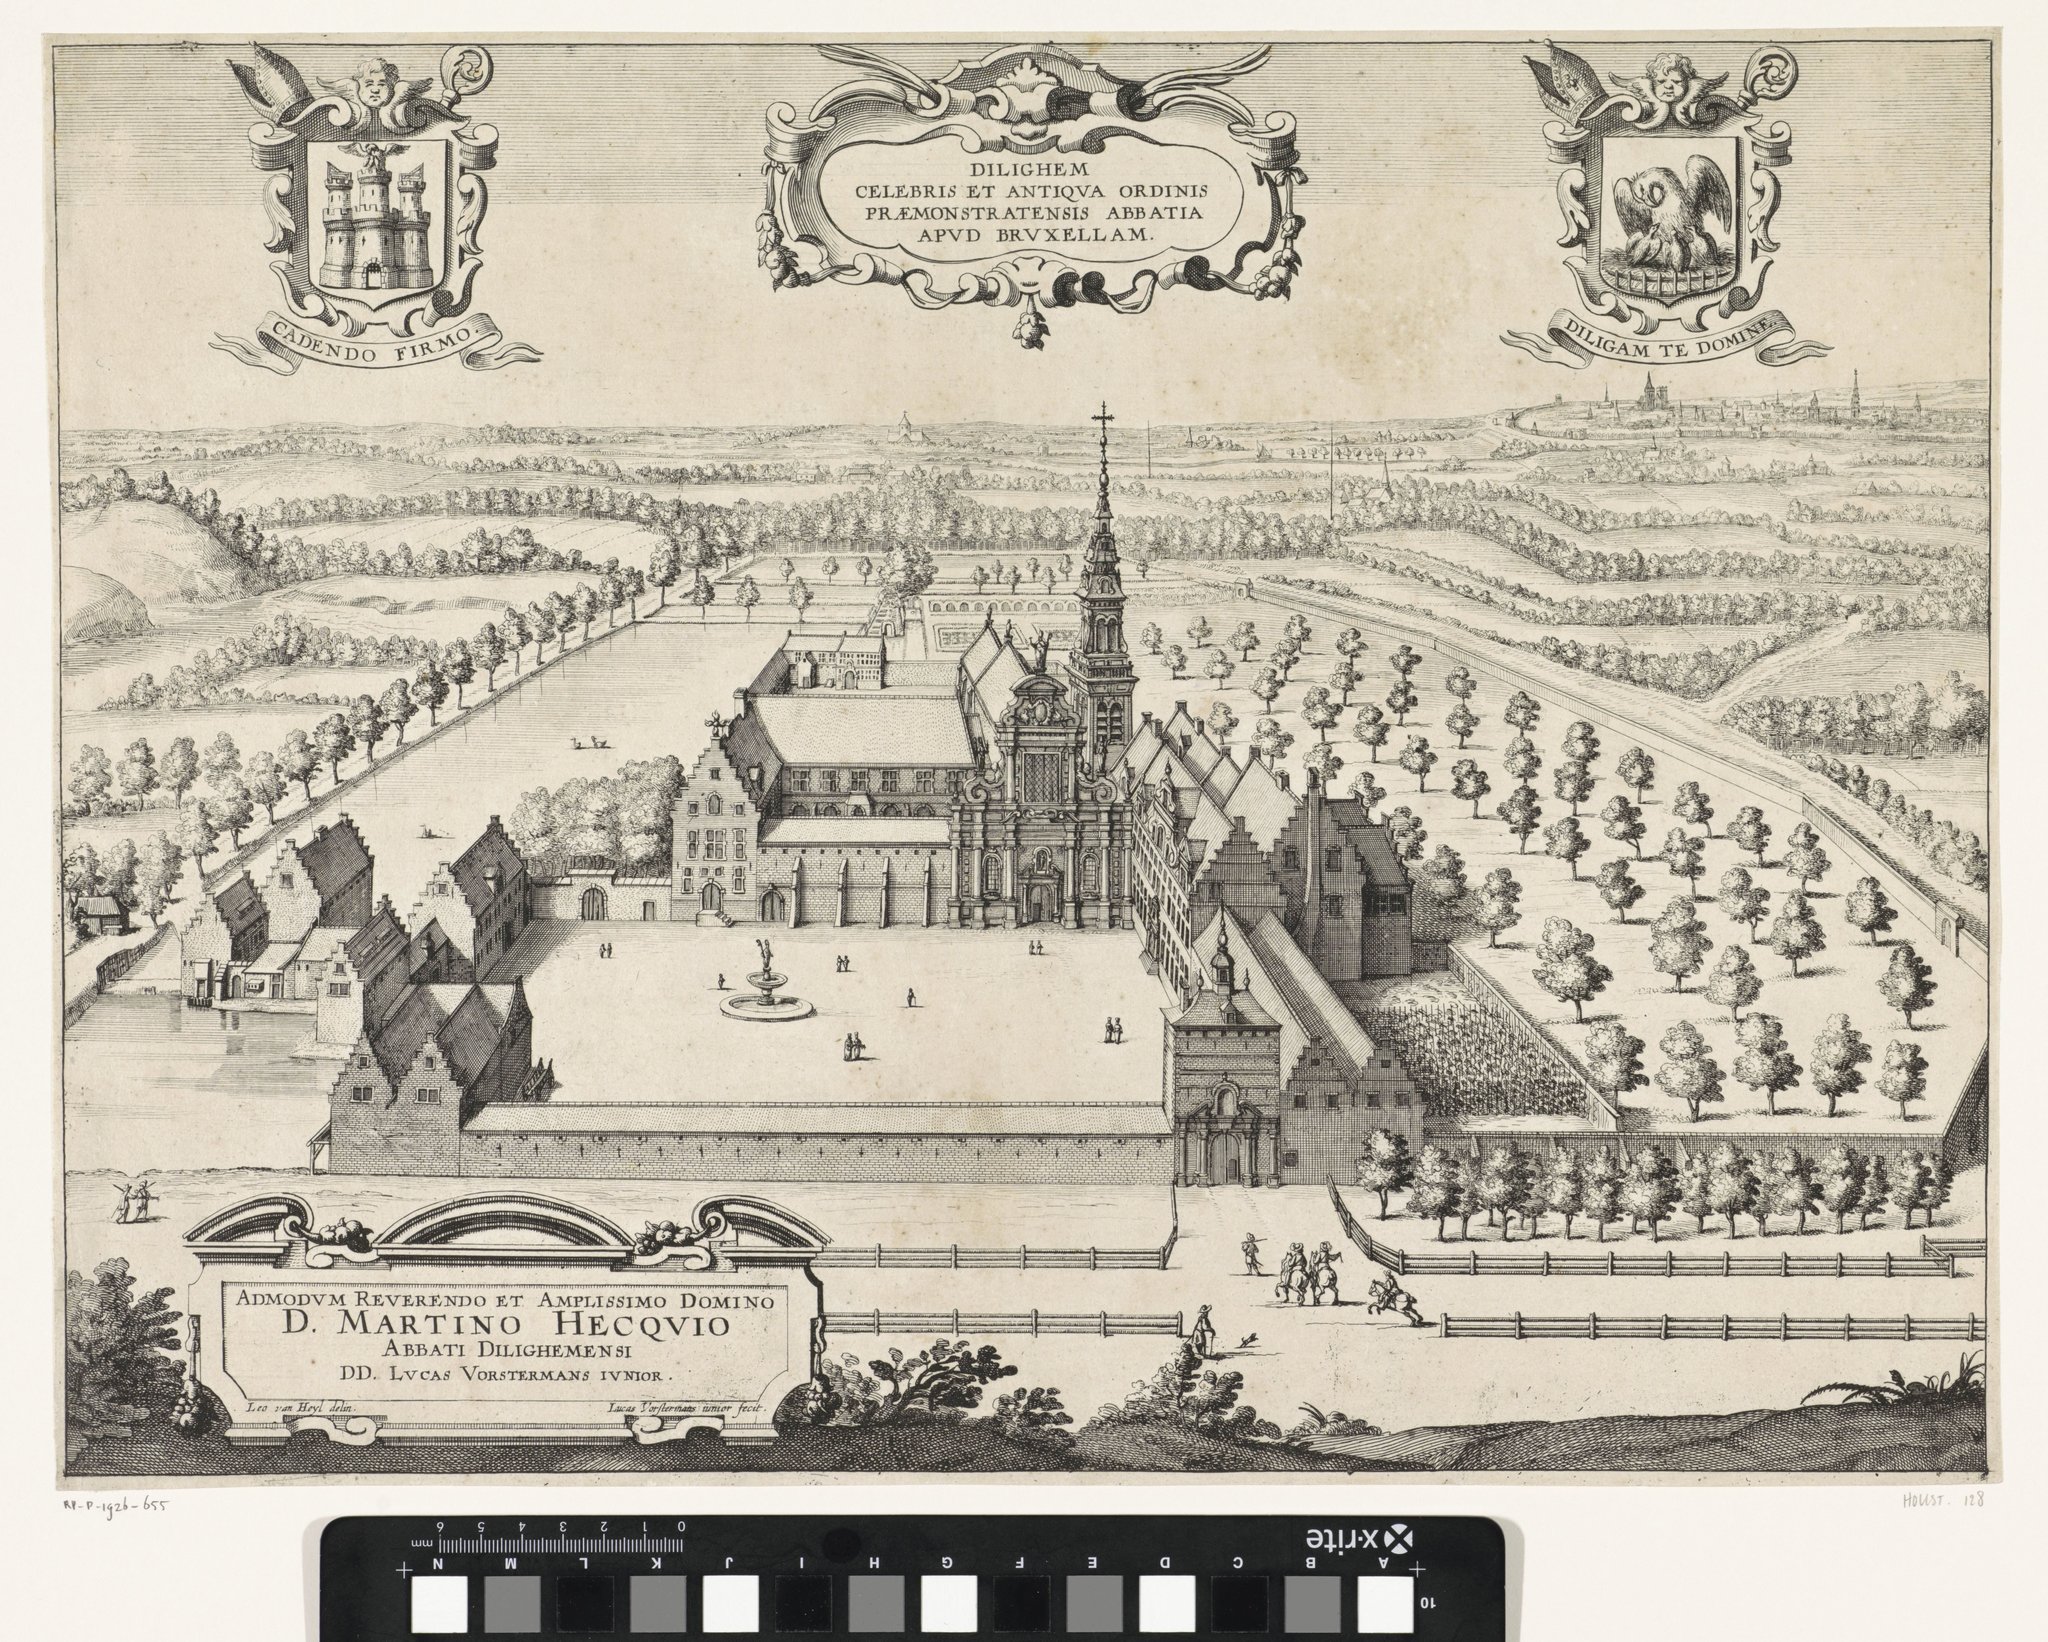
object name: print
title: Abdij van Dieleghem, bij Brussel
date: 1651-1667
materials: paper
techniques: engraving, etching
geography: antwerp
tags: abbey, monastery, convent ~ roman catholic church, brussels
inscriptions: collector's mark: Lugt 2166